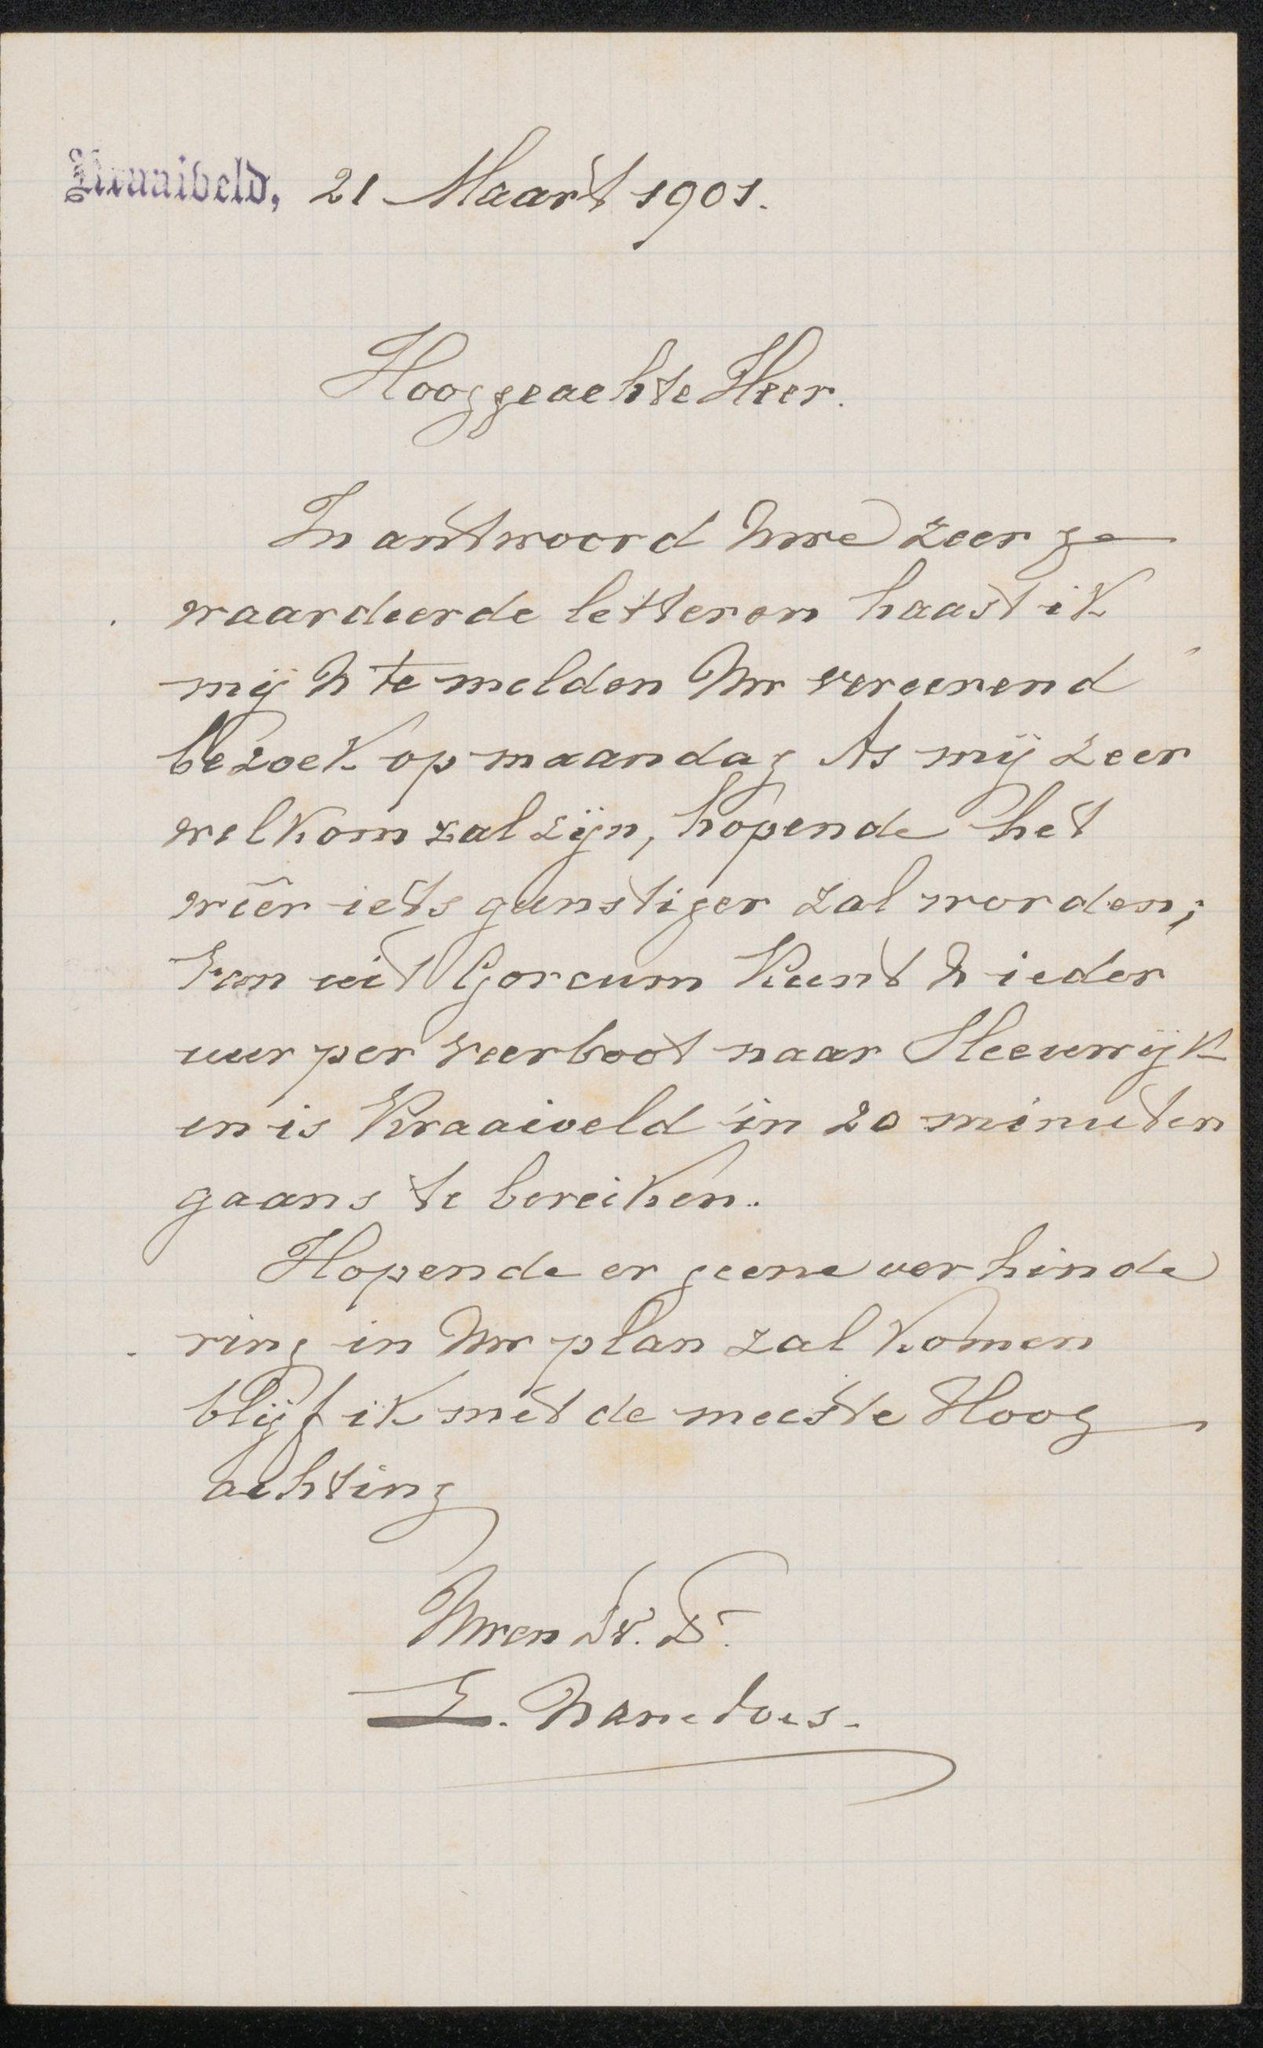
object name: letter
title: Brief aan Jan Veth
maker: louwrens hanedoes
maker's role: painter, print maker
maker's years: 1822-1905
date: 1900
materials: ink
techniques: pen, writing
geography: kraaiveld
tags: dordrecht, draughtsman, designer, jan veth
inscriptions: address: ‘Kraaiveld,’, collector's mark: ‘RPK’